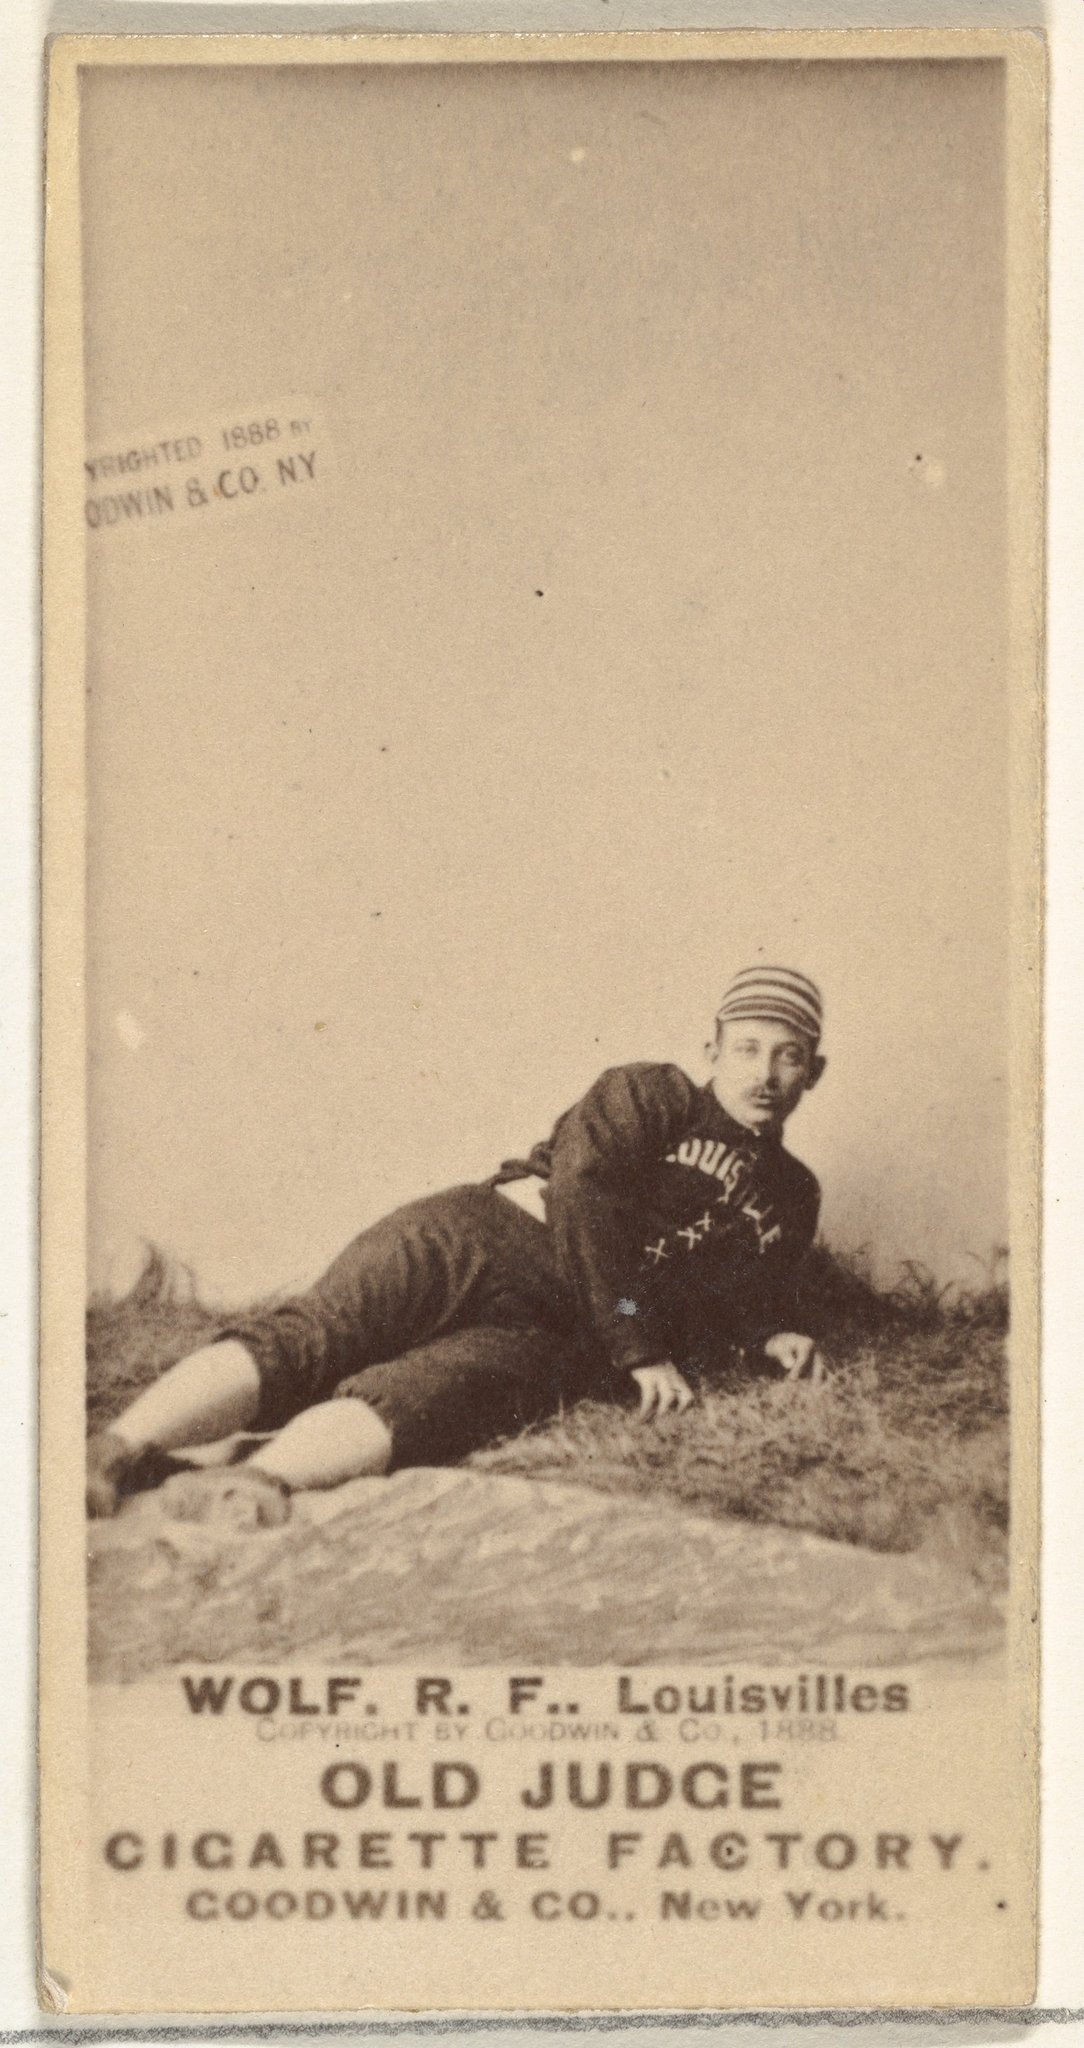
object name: baseball card, photograph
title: William Van Winkle "Jimmy" Wolf, Right Field, Louisville Colonels, from the Old Judge series (N172) for Old Judge Cigarettes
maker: goodwin & company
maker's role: publisher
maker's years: 1850-1950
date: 1888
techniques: albumen silver print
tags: men,portraits,baseball,athletes